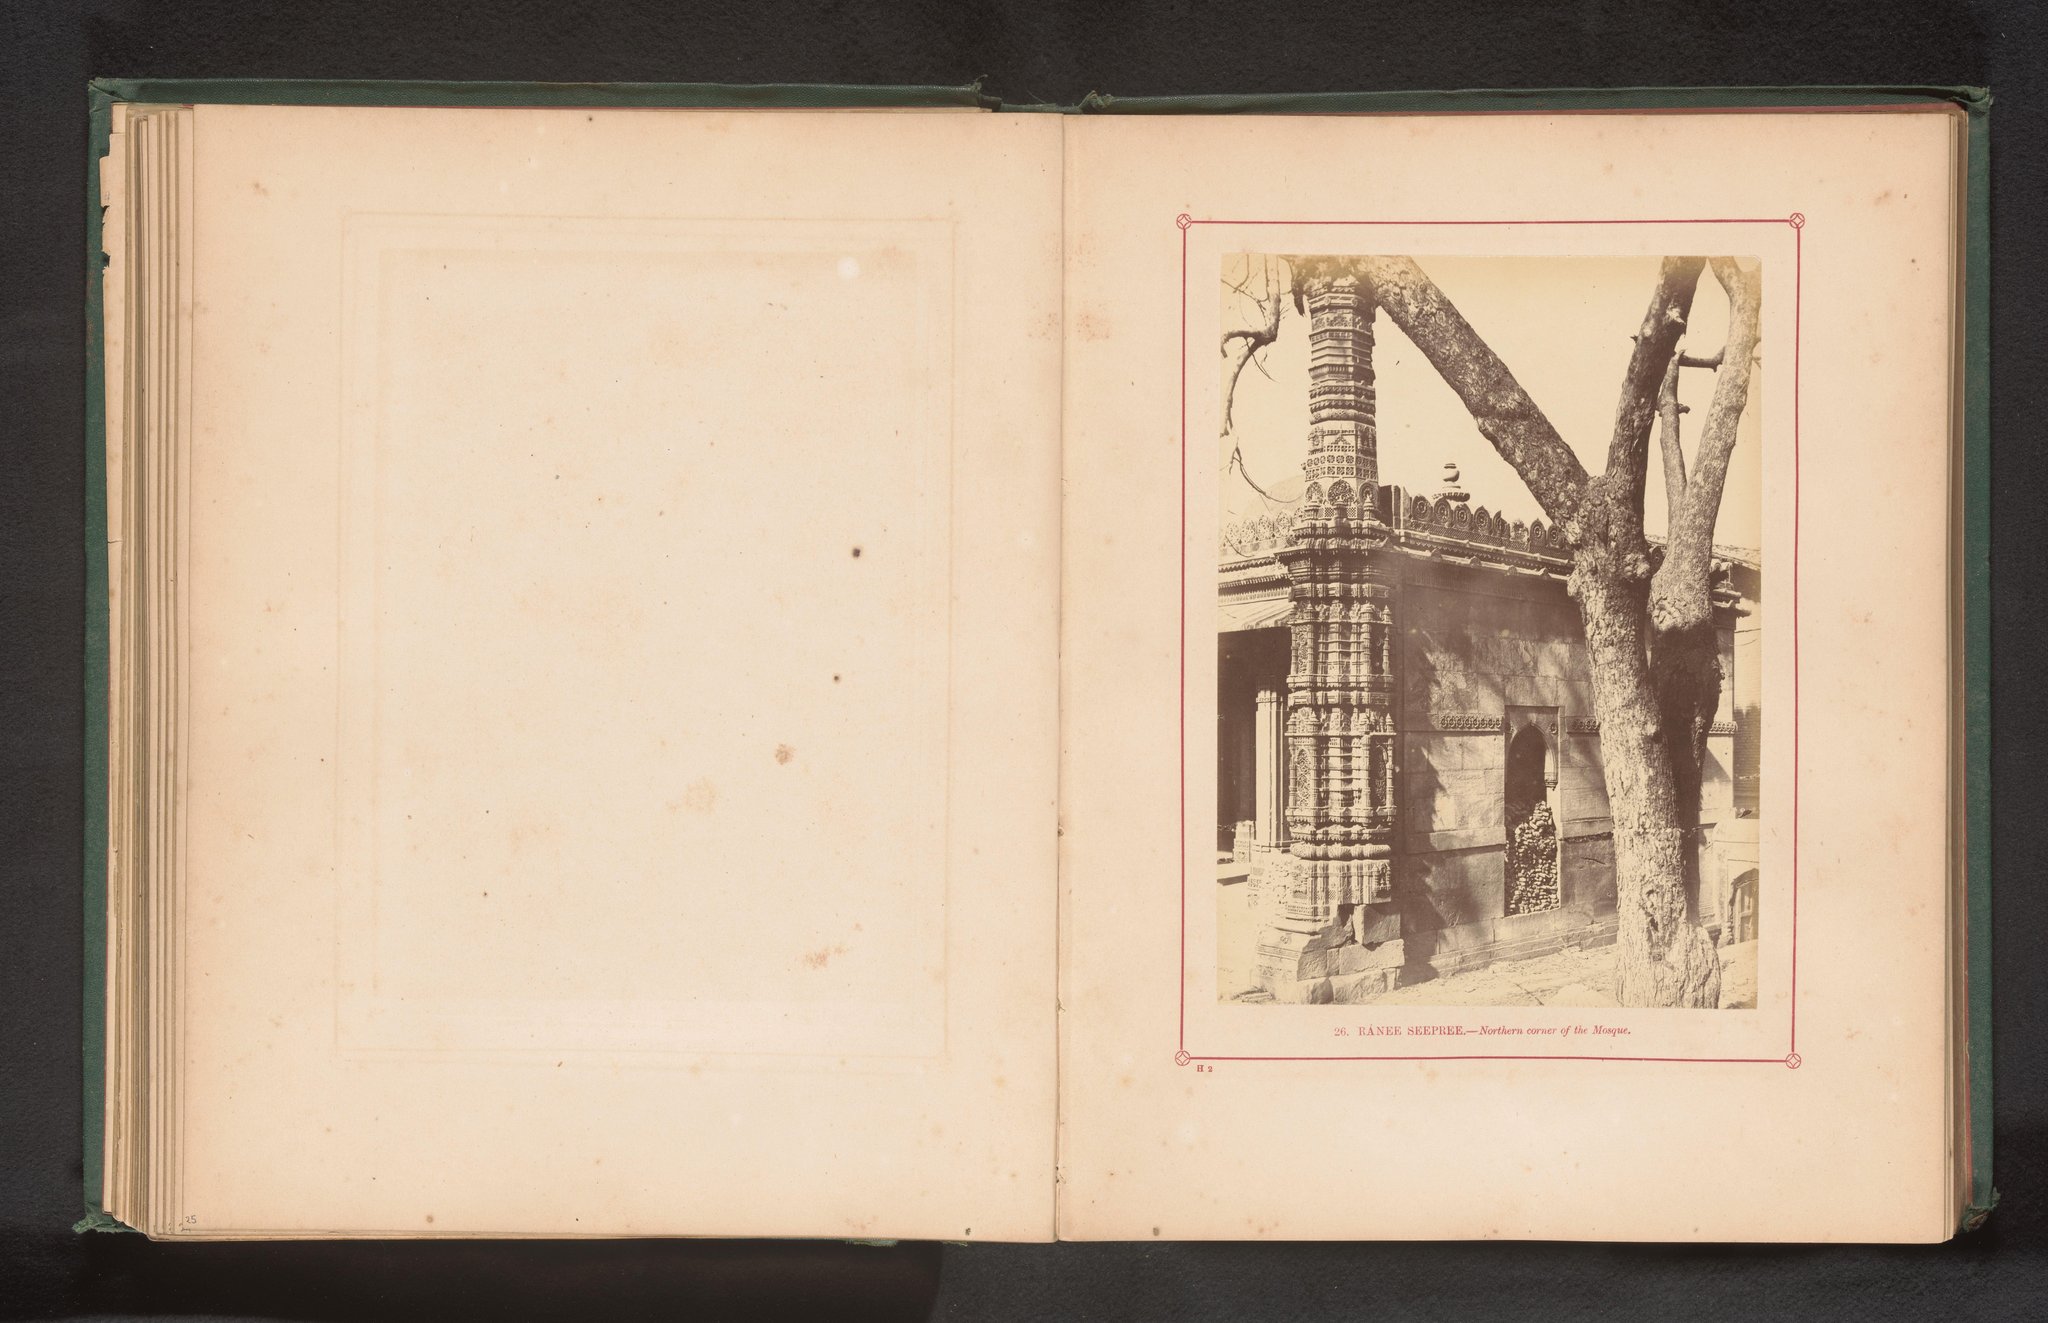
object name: photograph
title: Ránee Seepree.- Northern corner of the Mosque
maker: thomas biggs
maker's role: fotograaf, kapitein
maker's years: 1822-1905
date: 1856-1866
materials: photographic support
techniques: albumen print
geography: ahmedabad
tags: column, pillar ~ architecture, temple, shrine ~ islam, mohammedanism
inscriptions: number: ‘26.’, inscription: ‘H2’